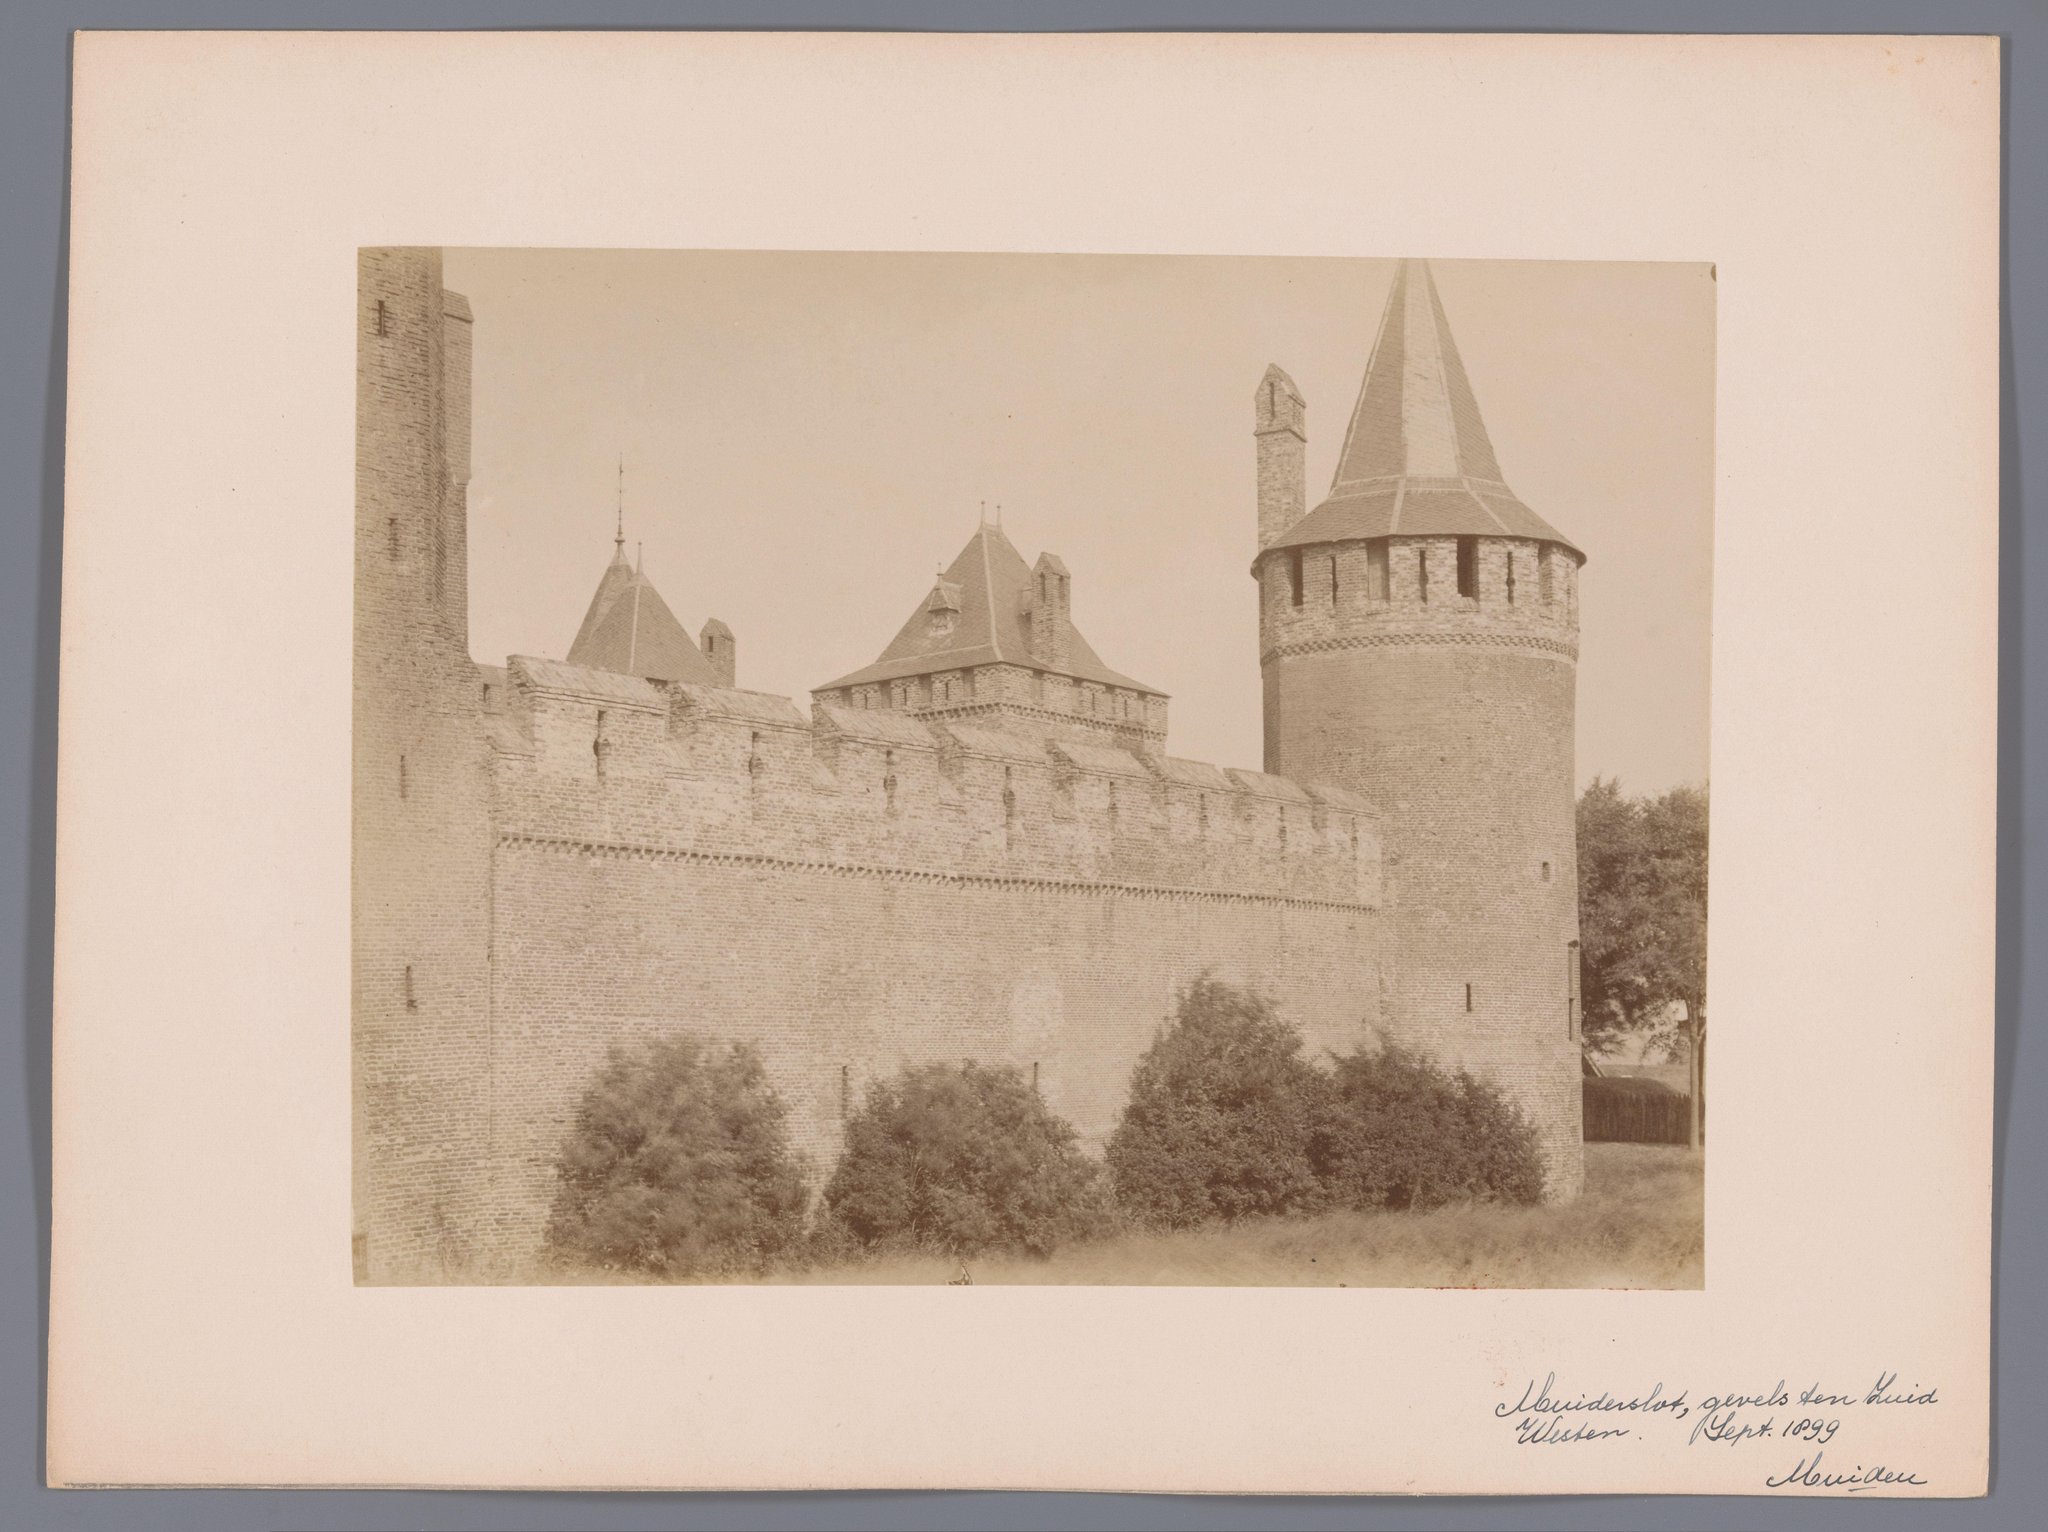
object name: photograph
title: Gezicht op het Muiderslot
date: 1899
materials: cardboard, photographic support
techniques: albumen print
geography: muiden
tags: castle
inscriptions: annotation: ‘Muiderslot, gevels ten Zuid Westen Sept. 1899/ Muiden’, annotation: ‘Slot te Muiden (N.H.)/ gevels ten zuidwesten/ sept 1899’